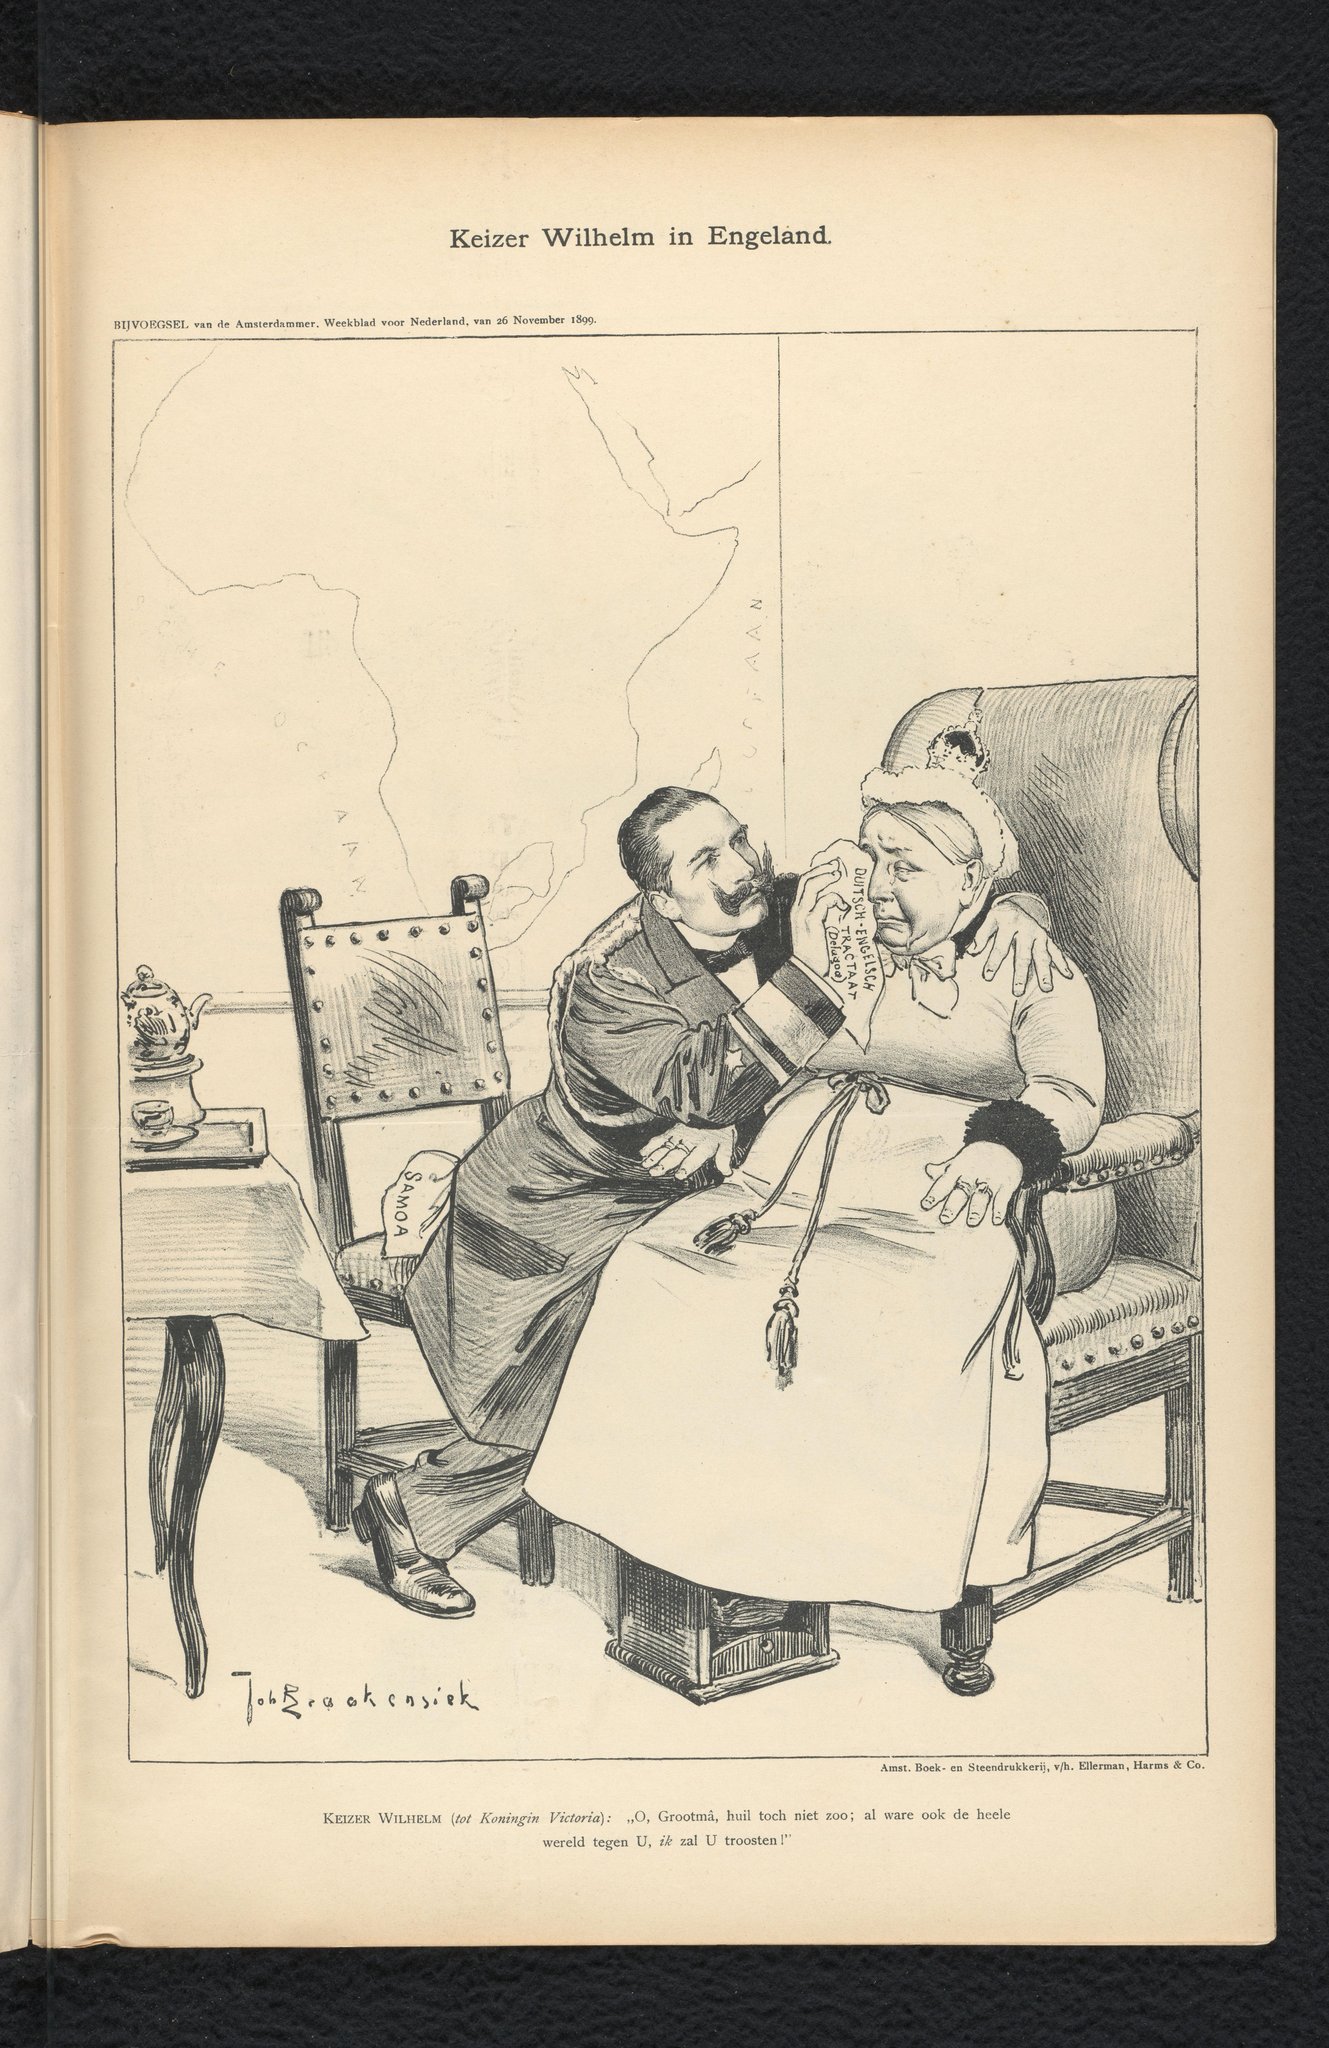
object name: cartoon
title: Keizer Wilhelm in Engeland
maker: johan braakensiek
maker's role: draughtsman, print maker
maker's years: 1858-1940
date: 1899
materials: paper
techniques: lithograph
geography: amsterdam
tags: victoria (koningin van het verenigd koninkrijk en keizerin van india), wilhelm ii (keizer van duitsland), tears, personifications of countries, nations, states, districts, etc., political caricatures and satires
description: De Duitse keizer Wilhelm II droogt de tranen van zijn huilende grootmoeder koningin Victoria met een zakdoek dat verwijst naar een Duits-Engels traktaat over de Delagoabaai. Aan de wand een grote kaart van Afrika.